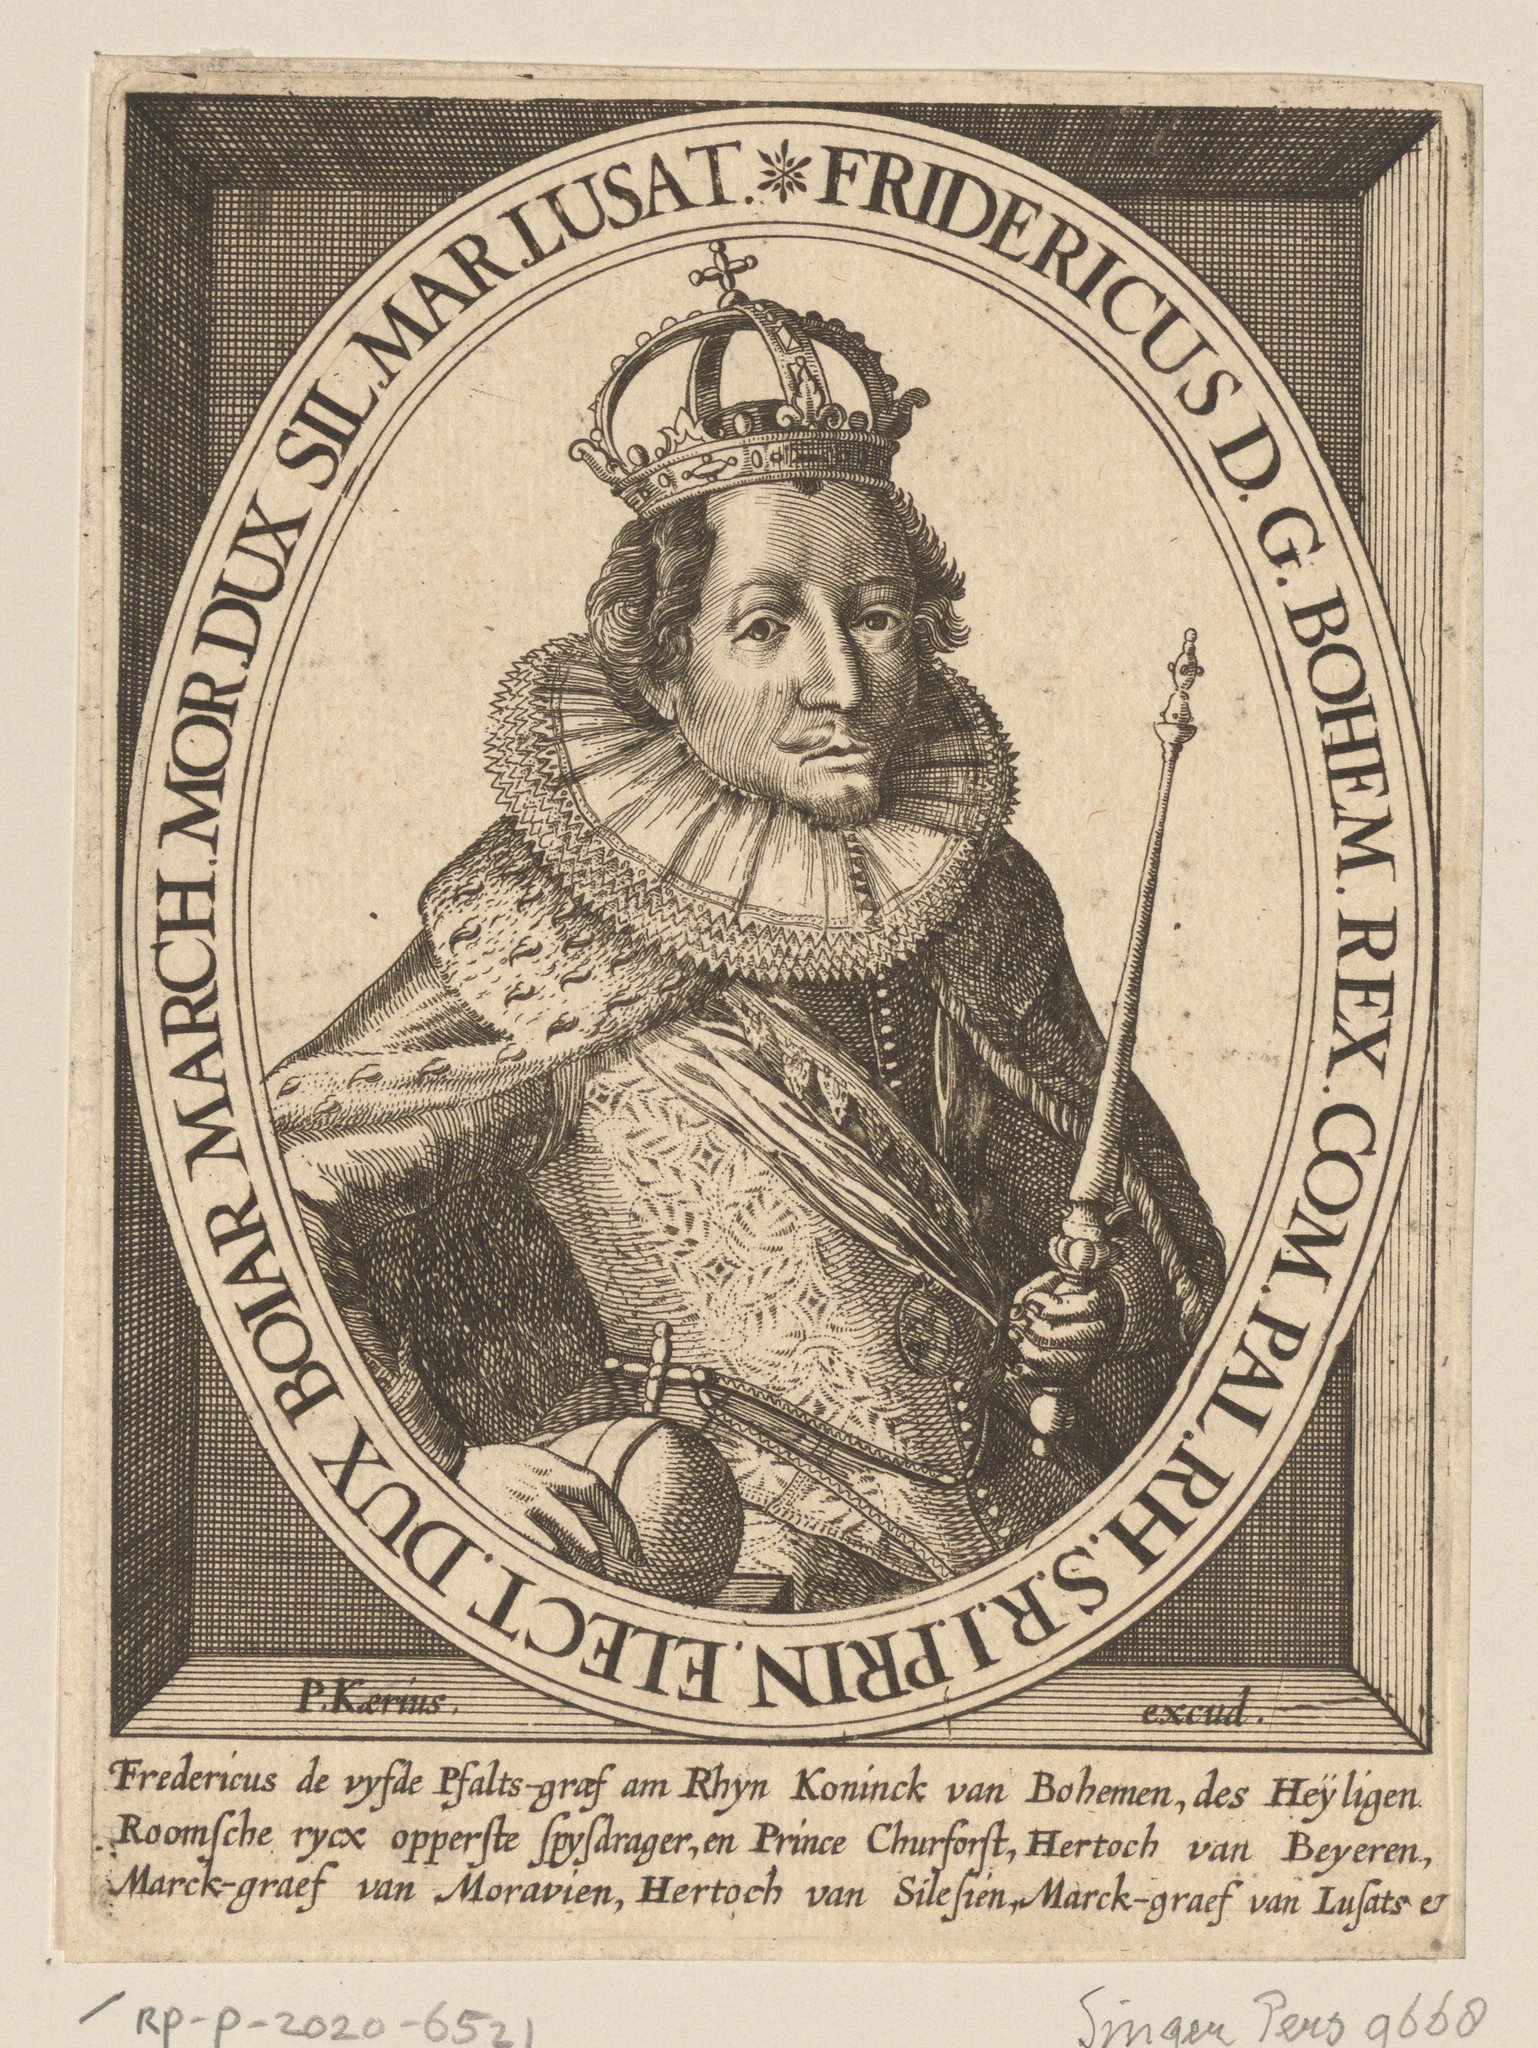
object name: print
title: Portret van Frederik V van de Palts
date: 1619-1646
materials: paper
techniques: engraving, etching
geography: northern netherlands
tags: amberg, frederik v (keurvorst van de palts, koning van bohemen), crown (symbol of sovereignty), orb (symbol of sovereignty; sphere with cross on top), sceptre, staff (symbol of sovereignty), historical persons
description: Met onderschrift in het Latijn. Rechtsboven: fol. 10.